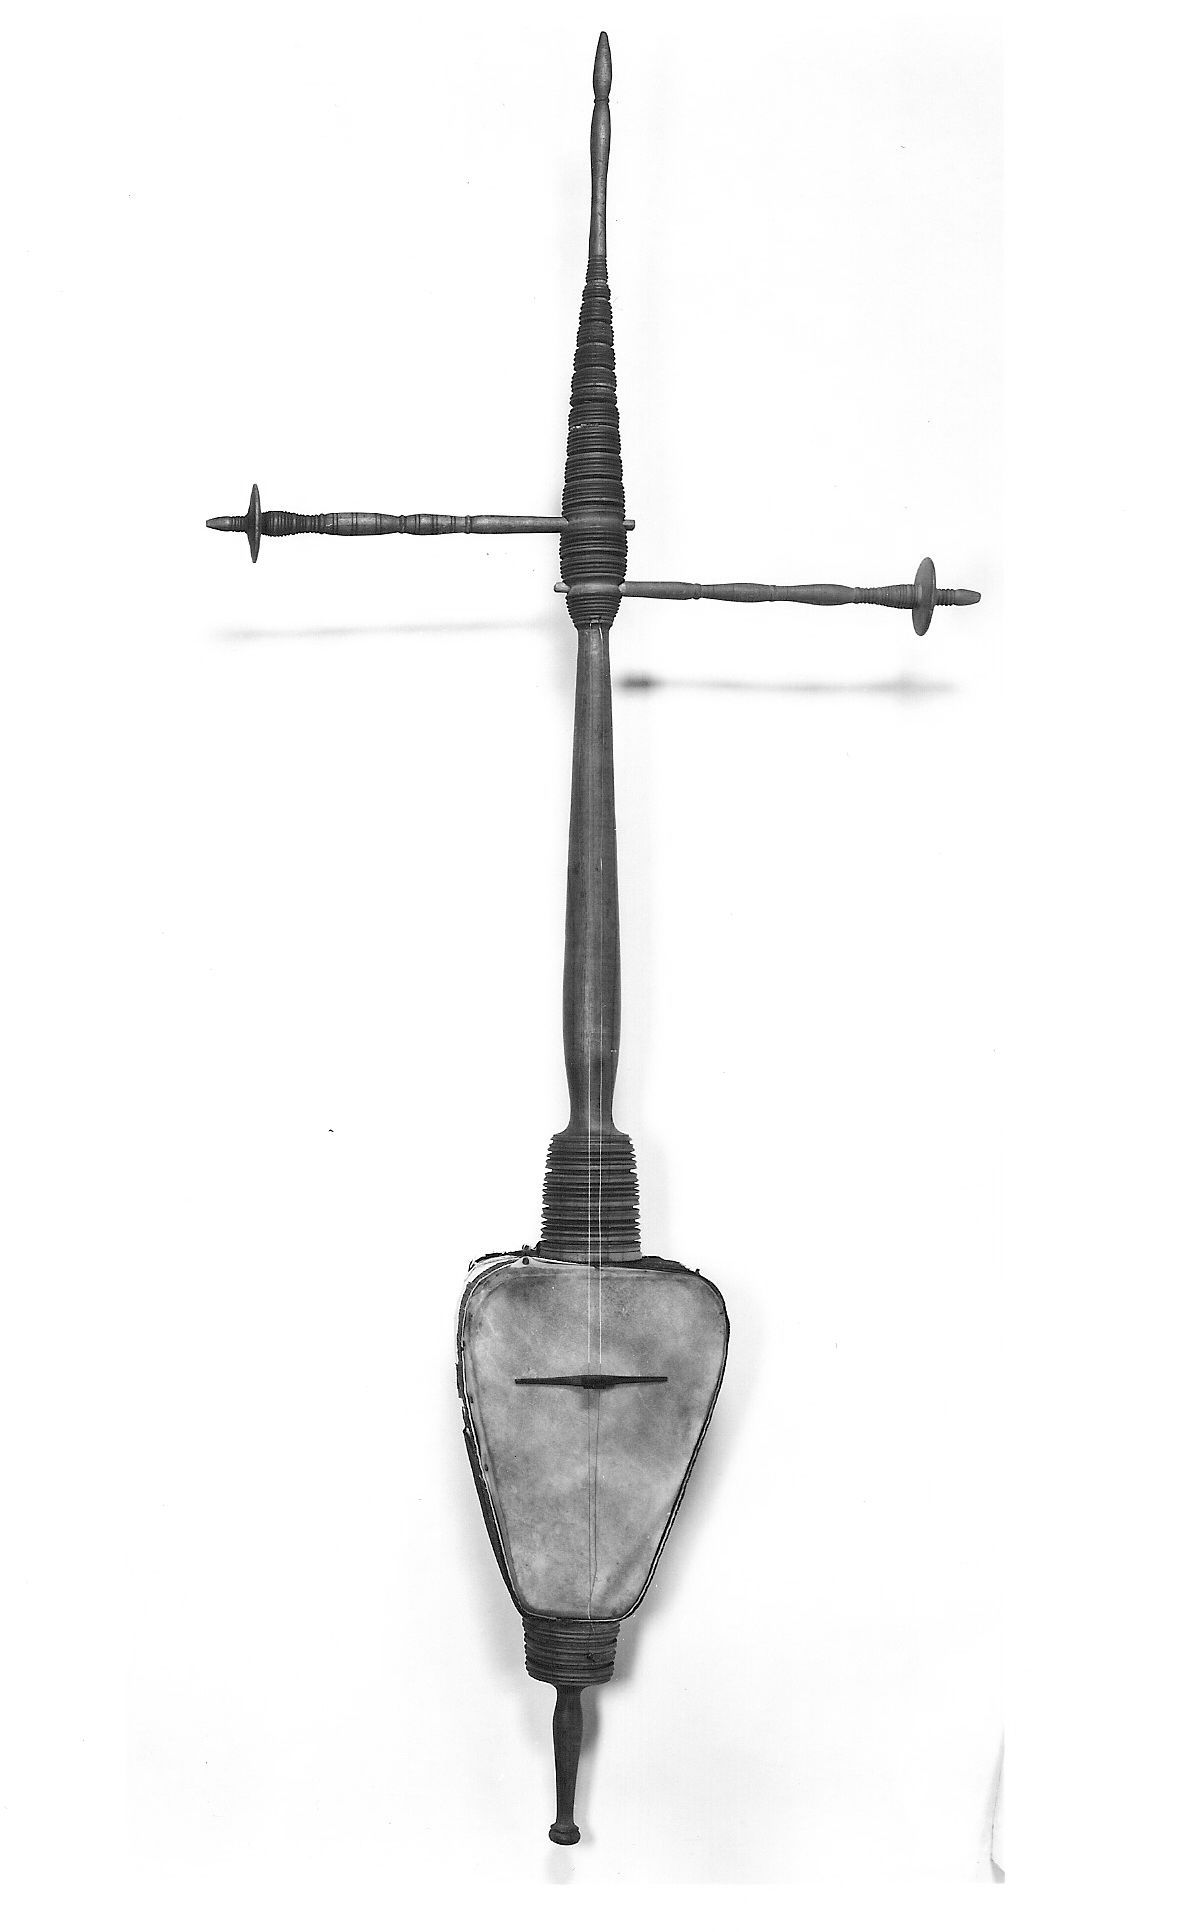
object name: rebab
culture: javanese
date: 1801-1900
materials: metal, wood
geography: indonesia